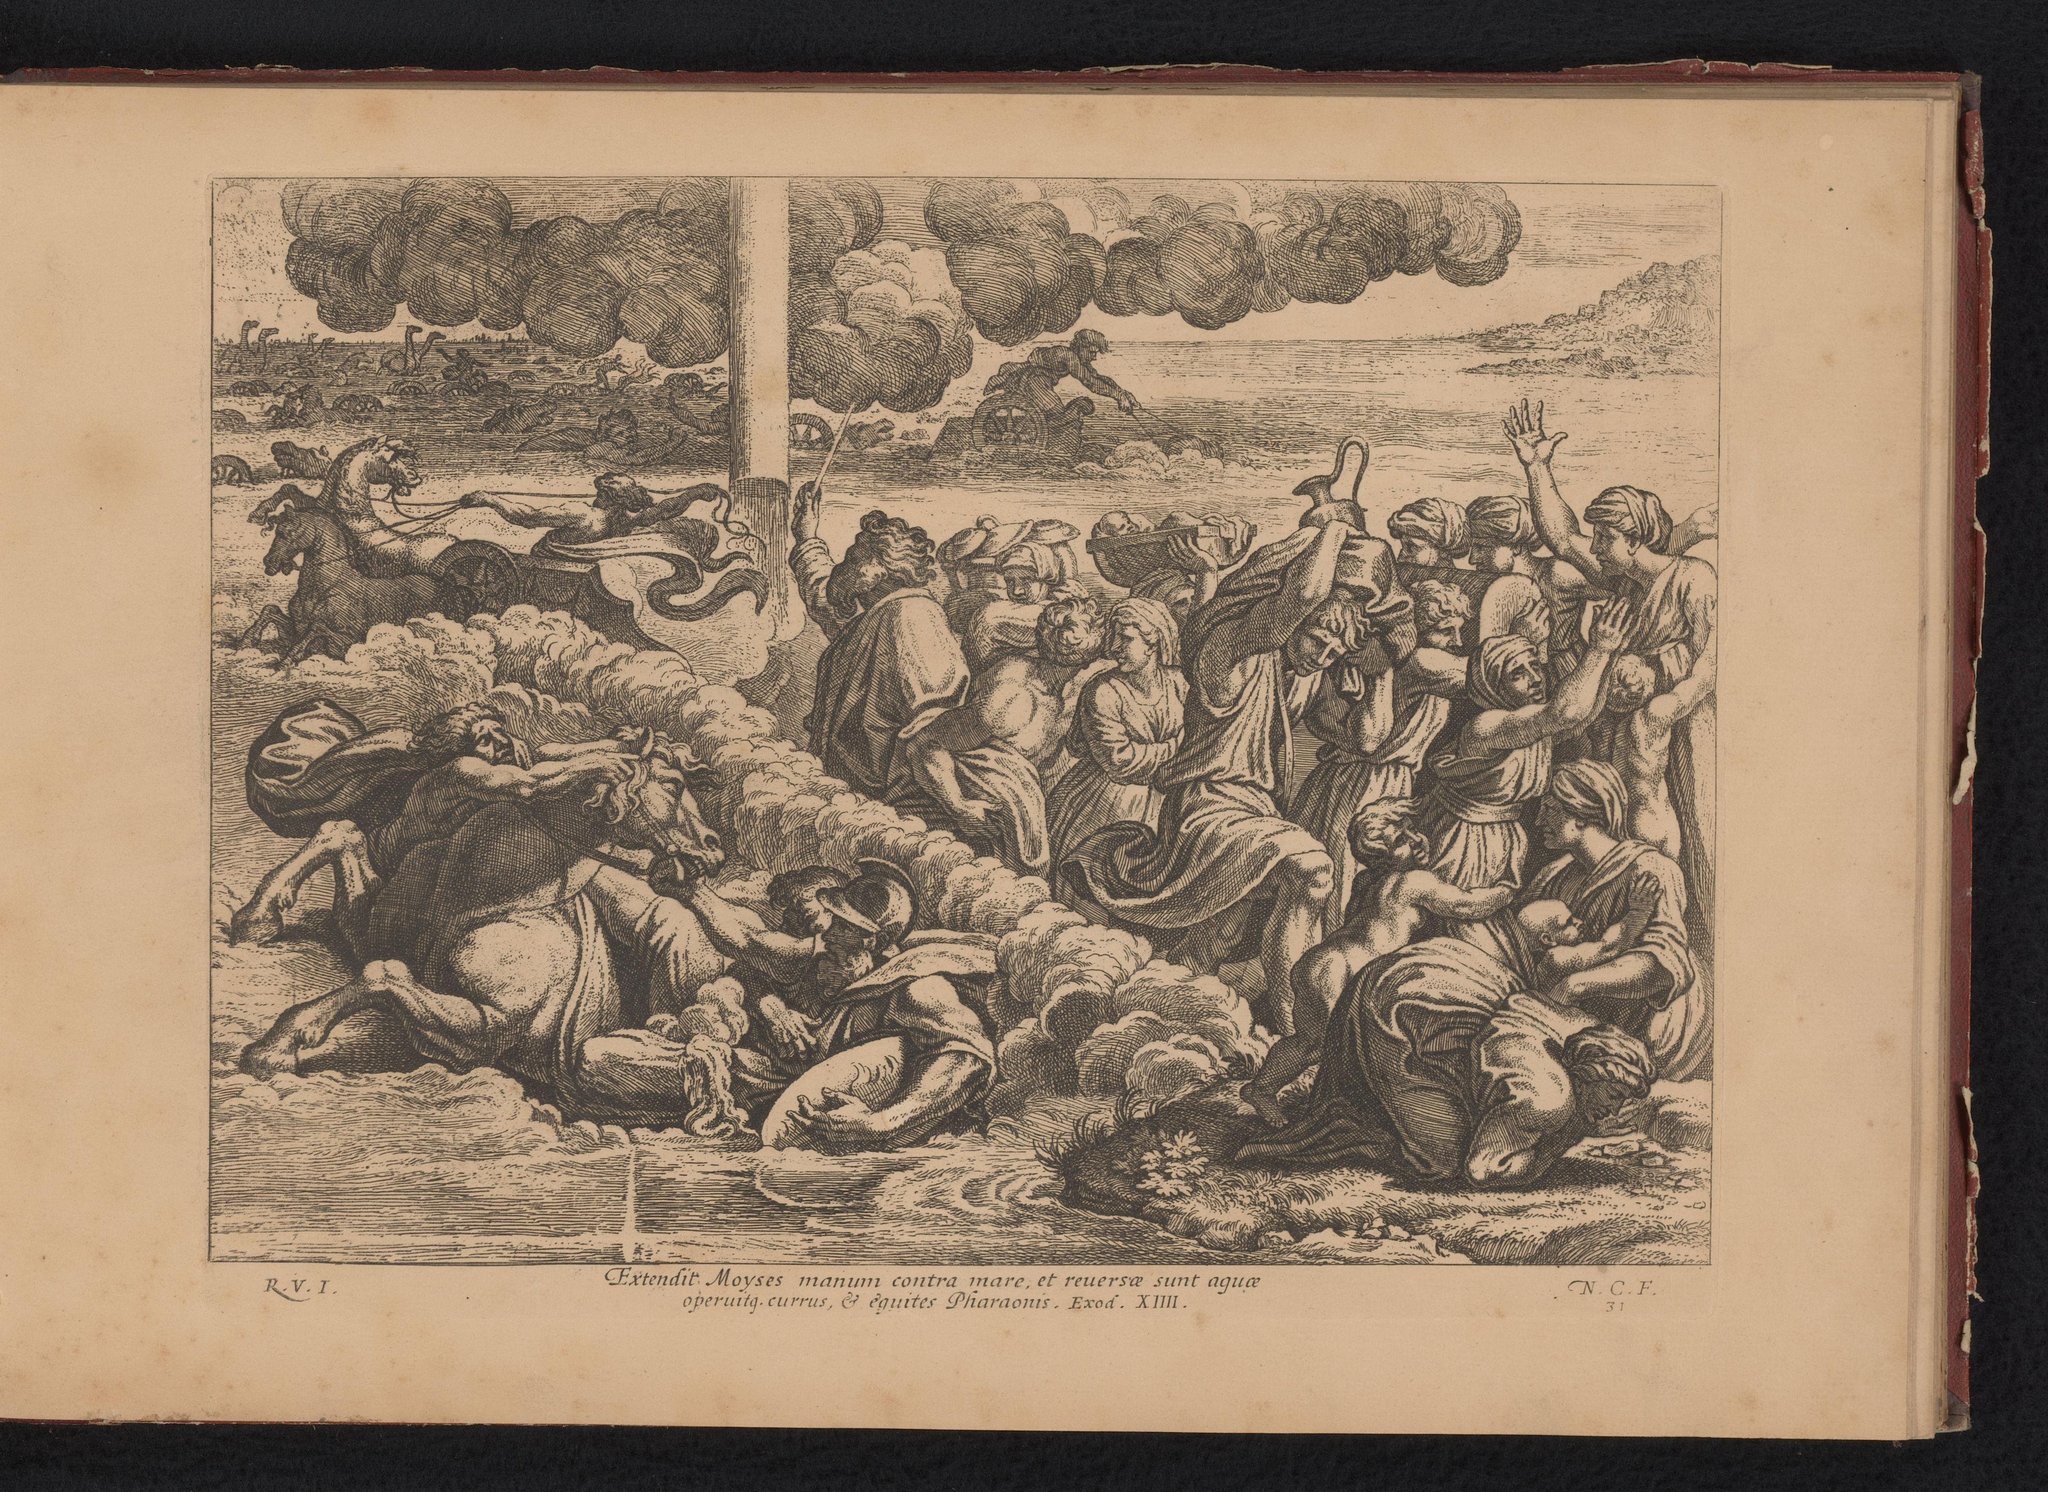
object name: album leaf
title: Sacrae historiae acta a Raphael Urbin in Vaticanis xystis ad picturae miraculum expressa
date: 1649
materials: paper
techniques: etching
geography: paris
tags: passage through the red sea, pharaoh and his army engulfed in the red sea (israelites not or barely visible)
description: Deze prent maakt deel uit van een album.